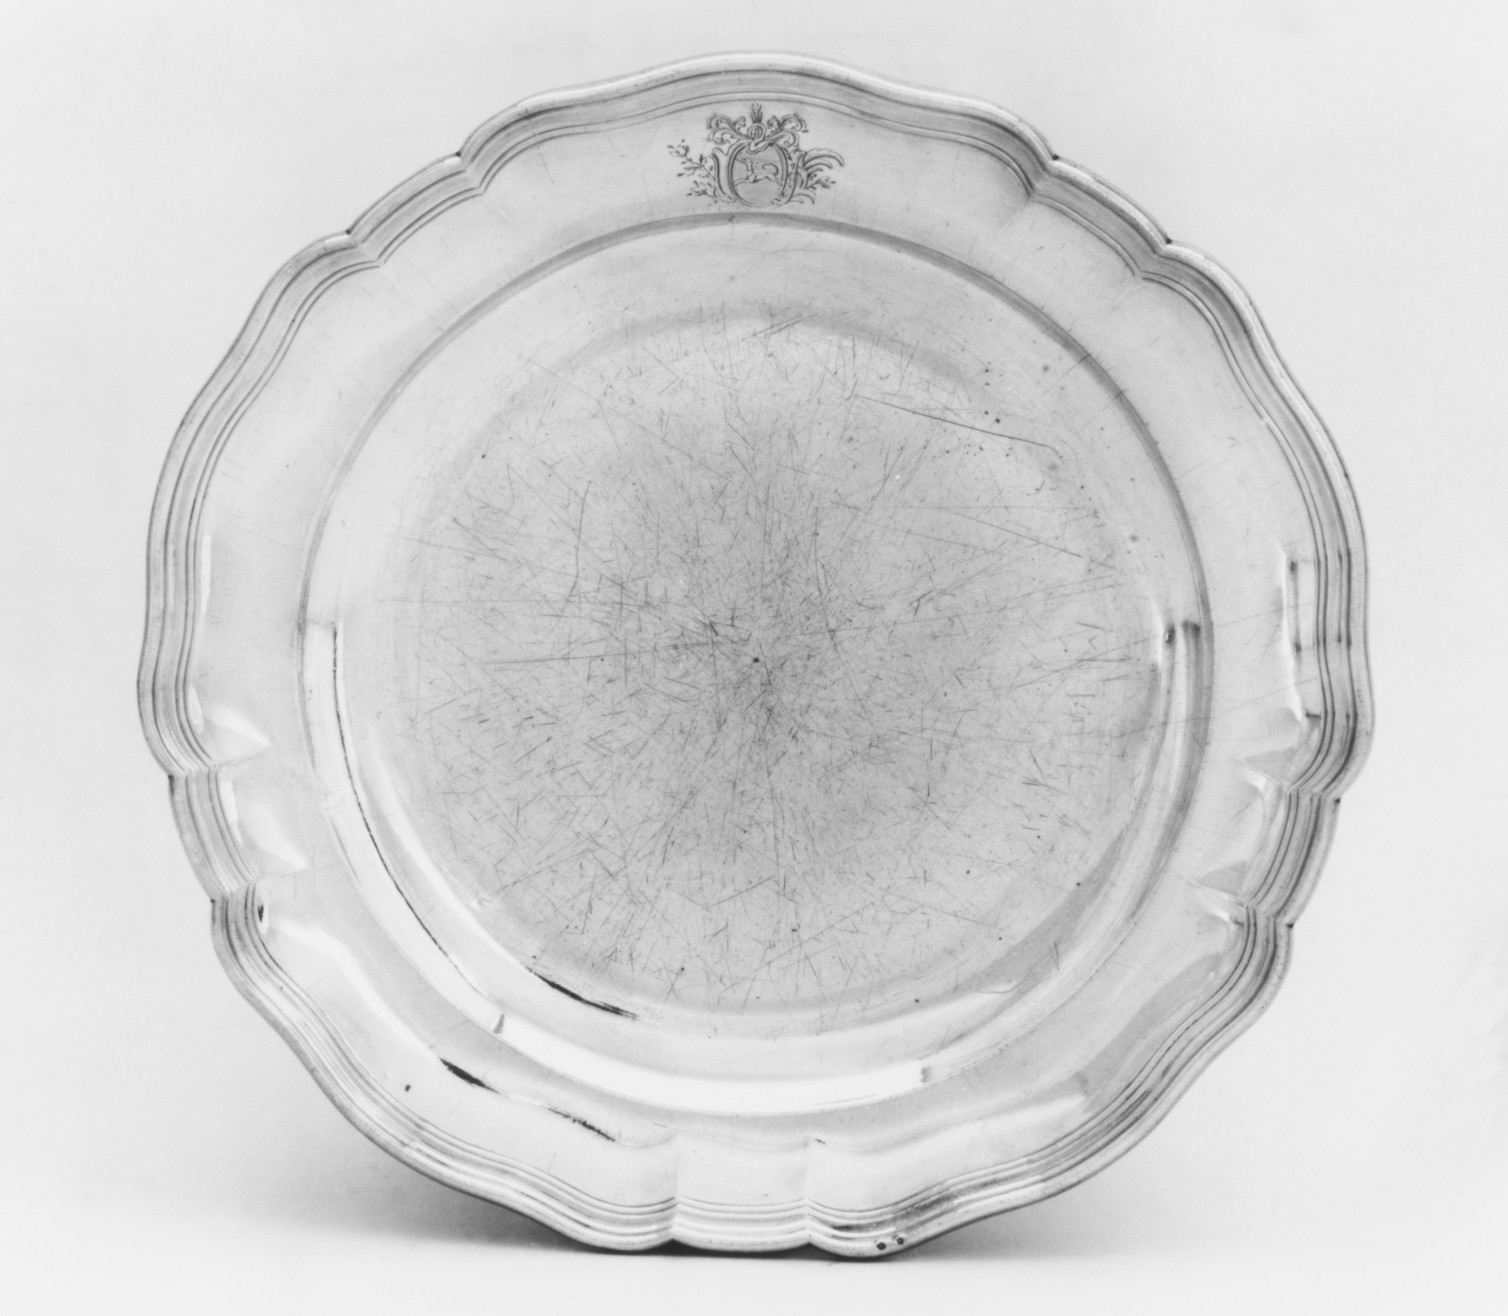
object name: plate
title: Plate (one of a set of two of graduated size)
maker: edme-pierre balzac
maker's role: maker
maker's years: 1705-1786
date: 1771-1772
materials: silver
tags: coat of arms